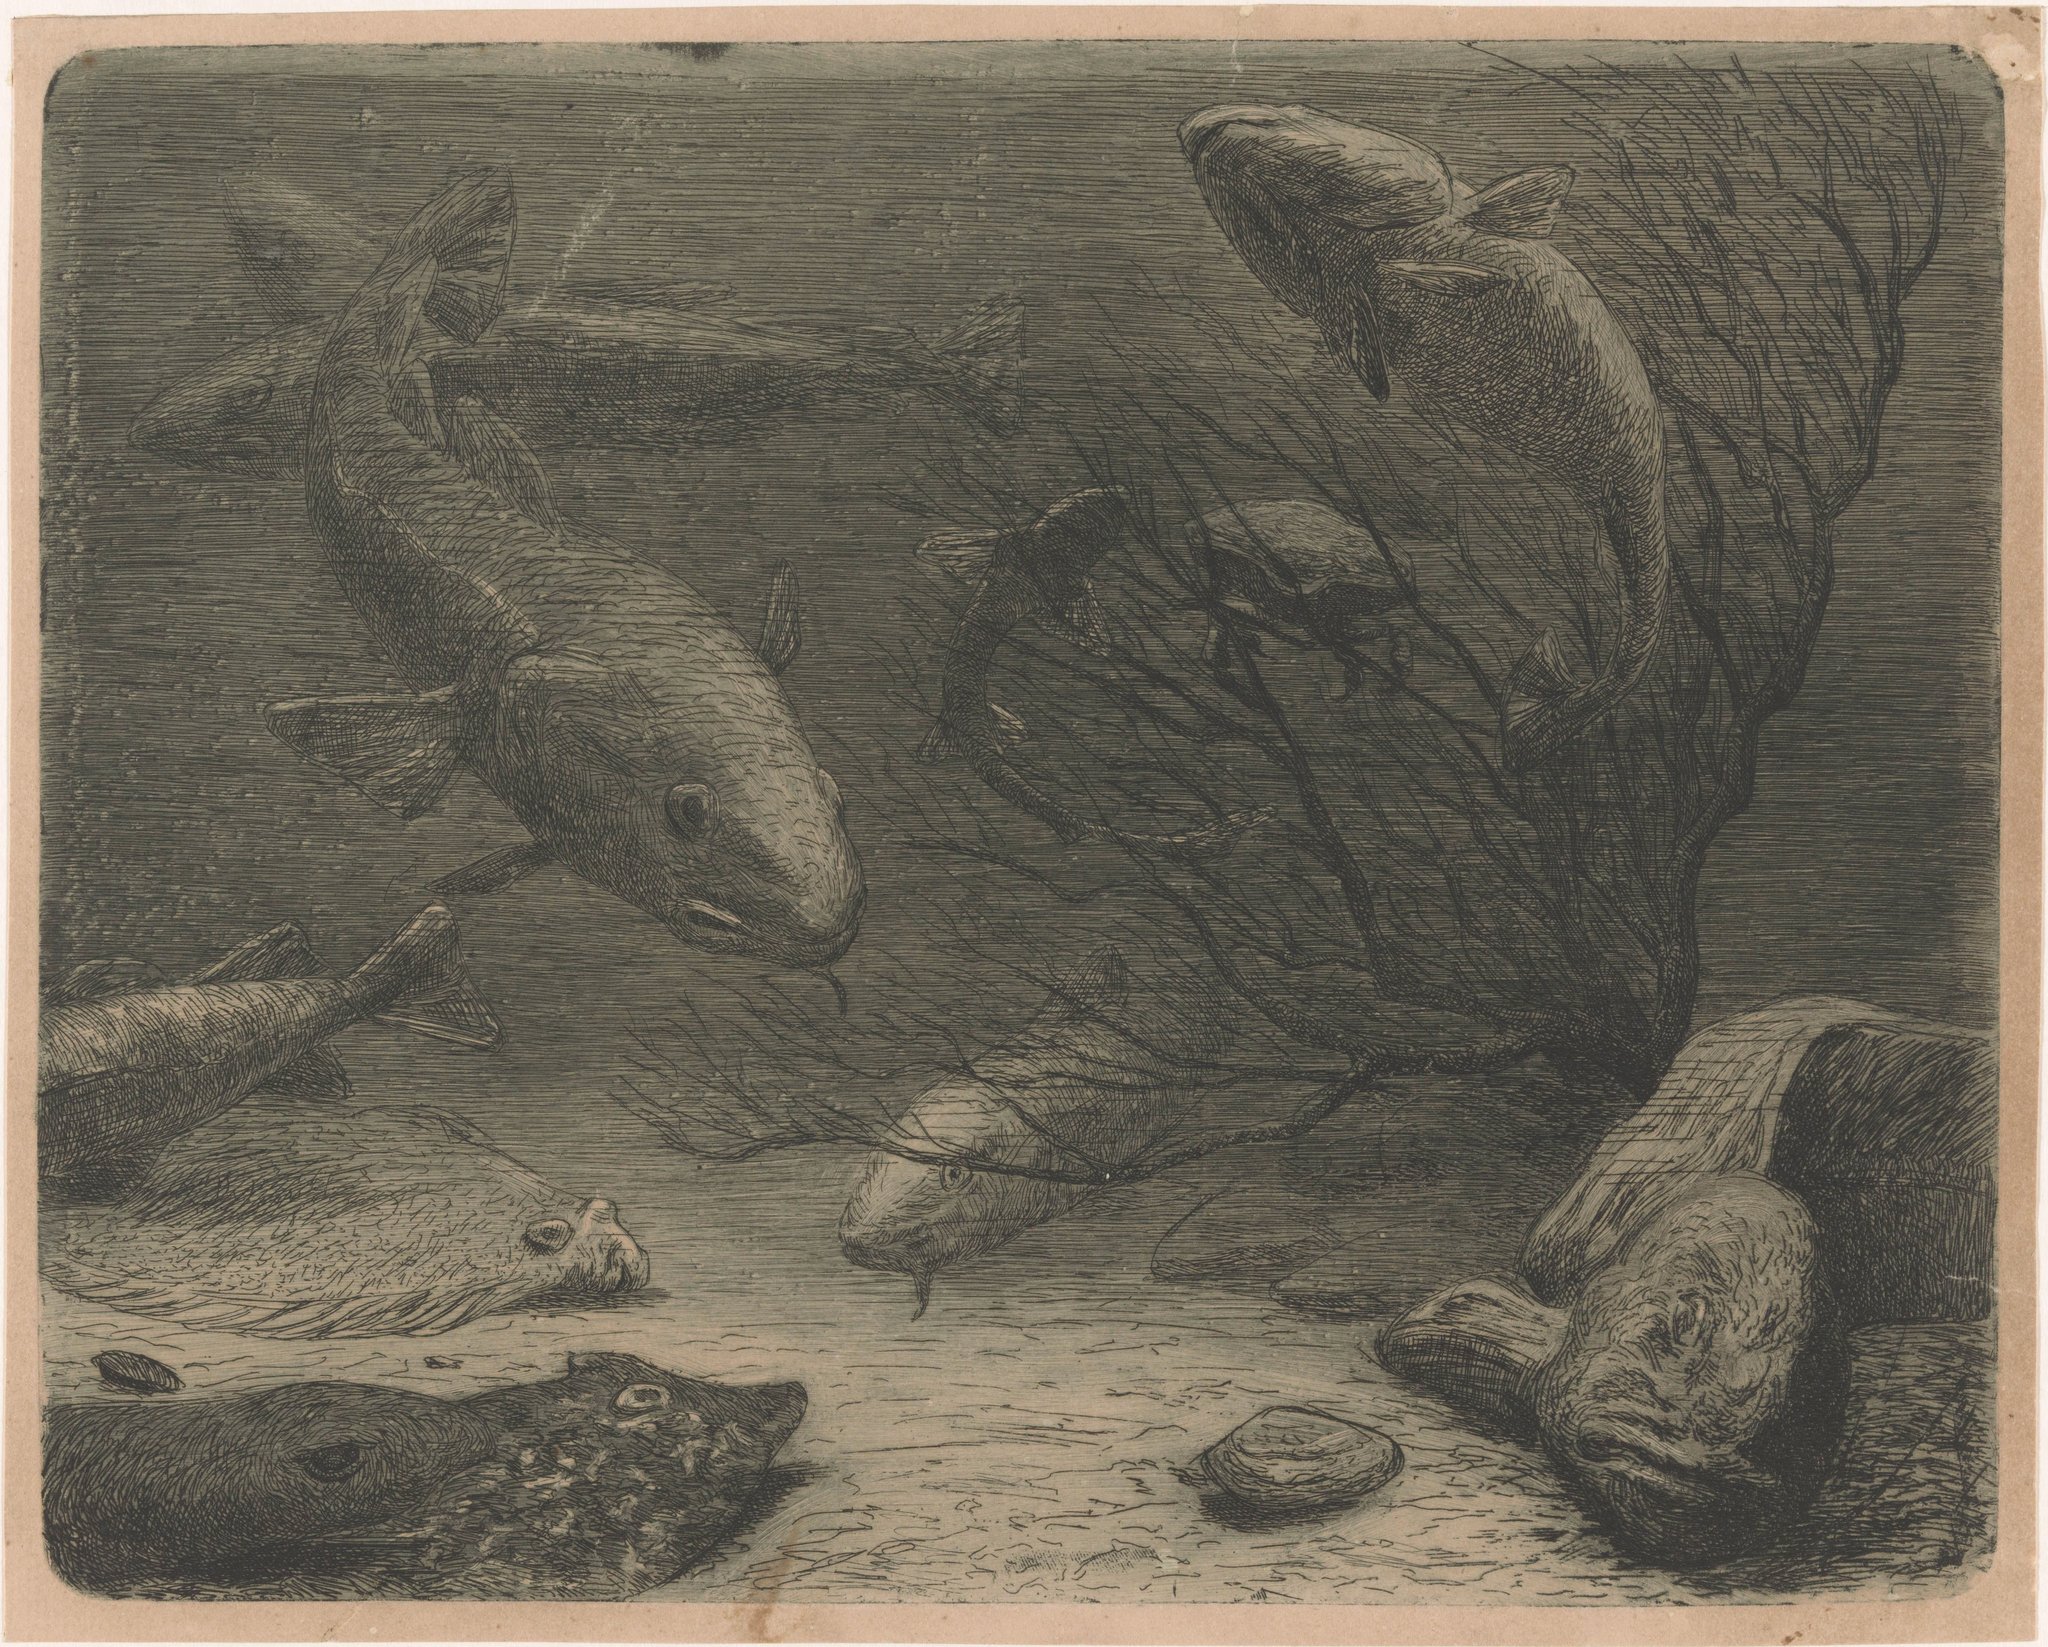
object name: print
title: Aquarium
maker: august le gras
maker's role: draughtsman, print maker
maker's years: 1864-1915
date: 1887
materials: paper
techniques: etching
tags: aquarium, crustaceans: crab, bony fishes: plaice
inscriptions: collector's mark: Lugt 2228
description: Aquarium met elf vissen en een krab. Links liggen twee schollen op de bodem. Rechts een waterplant.